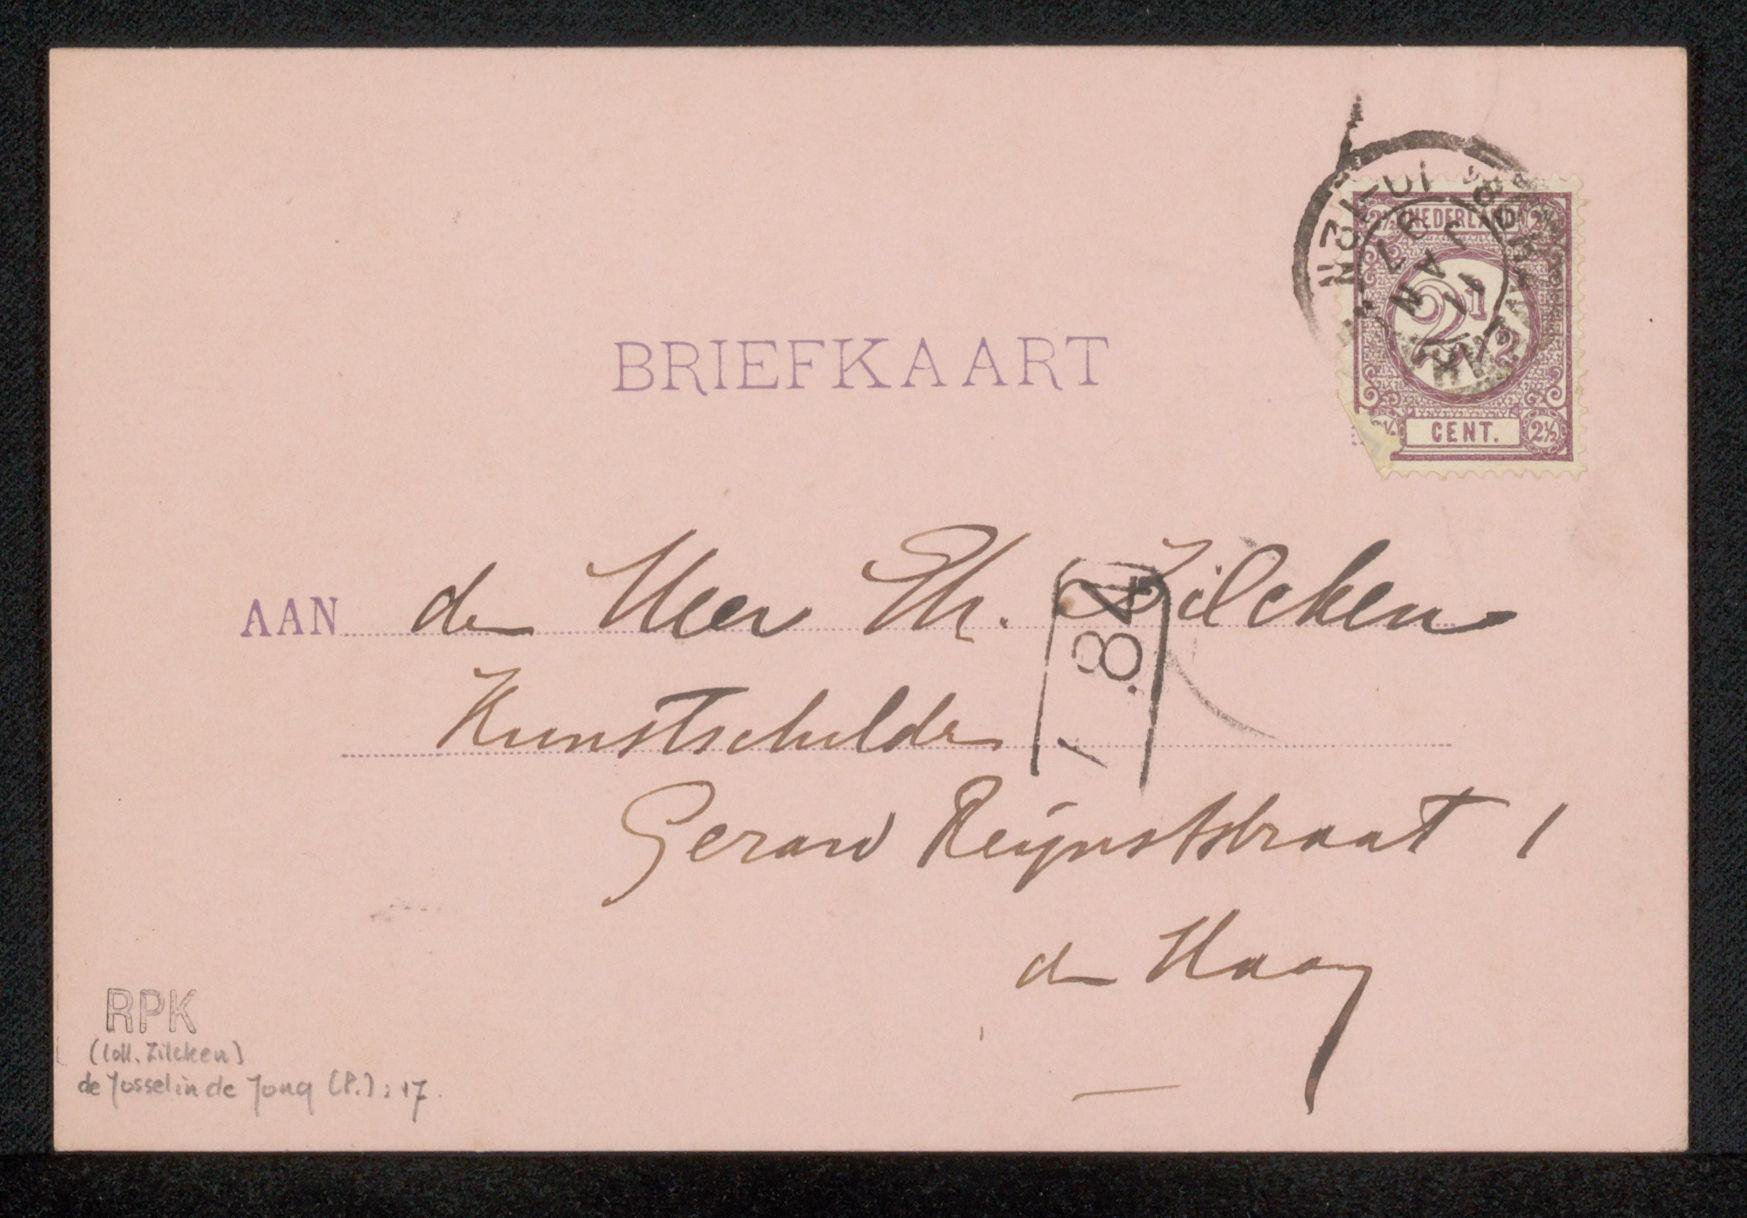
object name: postcard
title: Briefkaart aan Philip Zilcken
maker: pieter de josselin de jong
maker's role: draughtsman, painter, print maker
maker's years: 1861-1906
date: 1897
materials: cardboard, ink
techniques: writing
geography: the hague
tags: rotterdam, amsterdam, herman robbers, philip zilcken, literature ~ arts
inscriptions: collector's mark: ‘RPK’